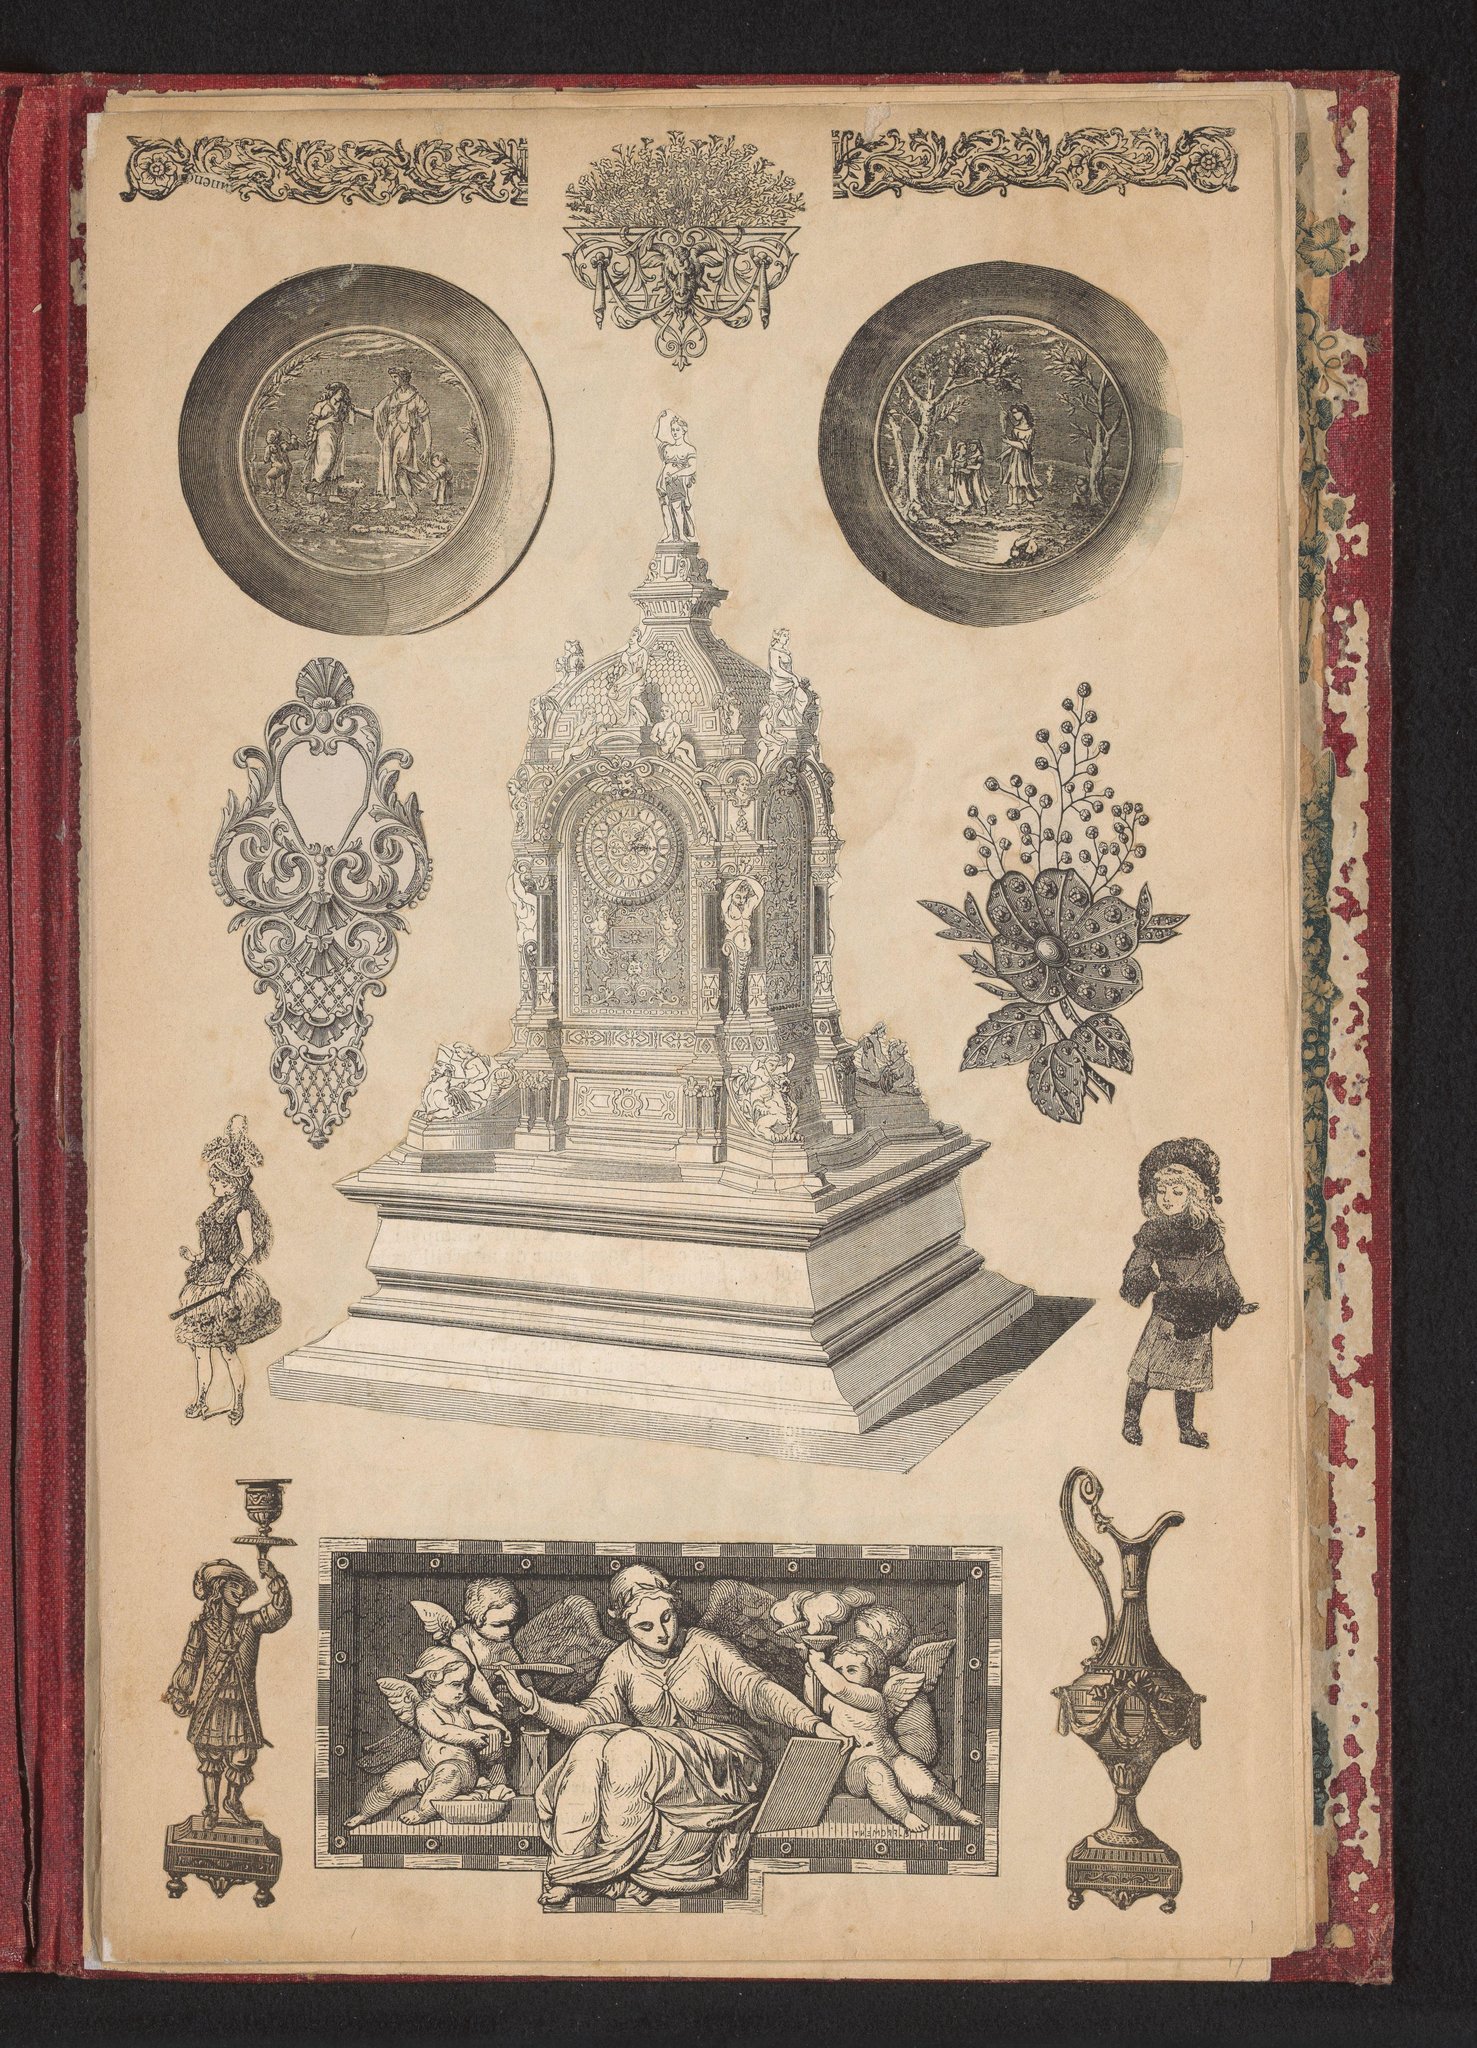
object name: print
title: Collage van uitgeknipte prenten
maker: Anonymous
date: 1870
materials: paper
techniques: engraving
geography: paris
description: Collage van uitgeknipte prenten. Onderdeel van een album met 18 bladen, aan beide zijden beplakt met uitgeknipte prenten, vermoedelijk afkomstig uit 19e-eeuwse tijdschiften.